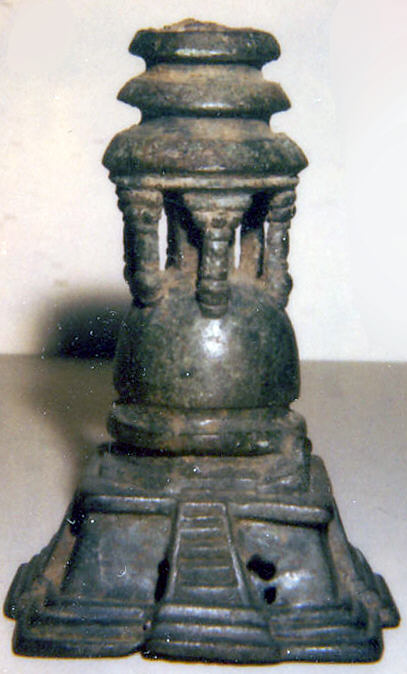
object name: reliquary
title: Reliquary in the Shape of a Stupa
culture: indian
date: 601-900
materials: copper alloy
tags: kashmir,stupas